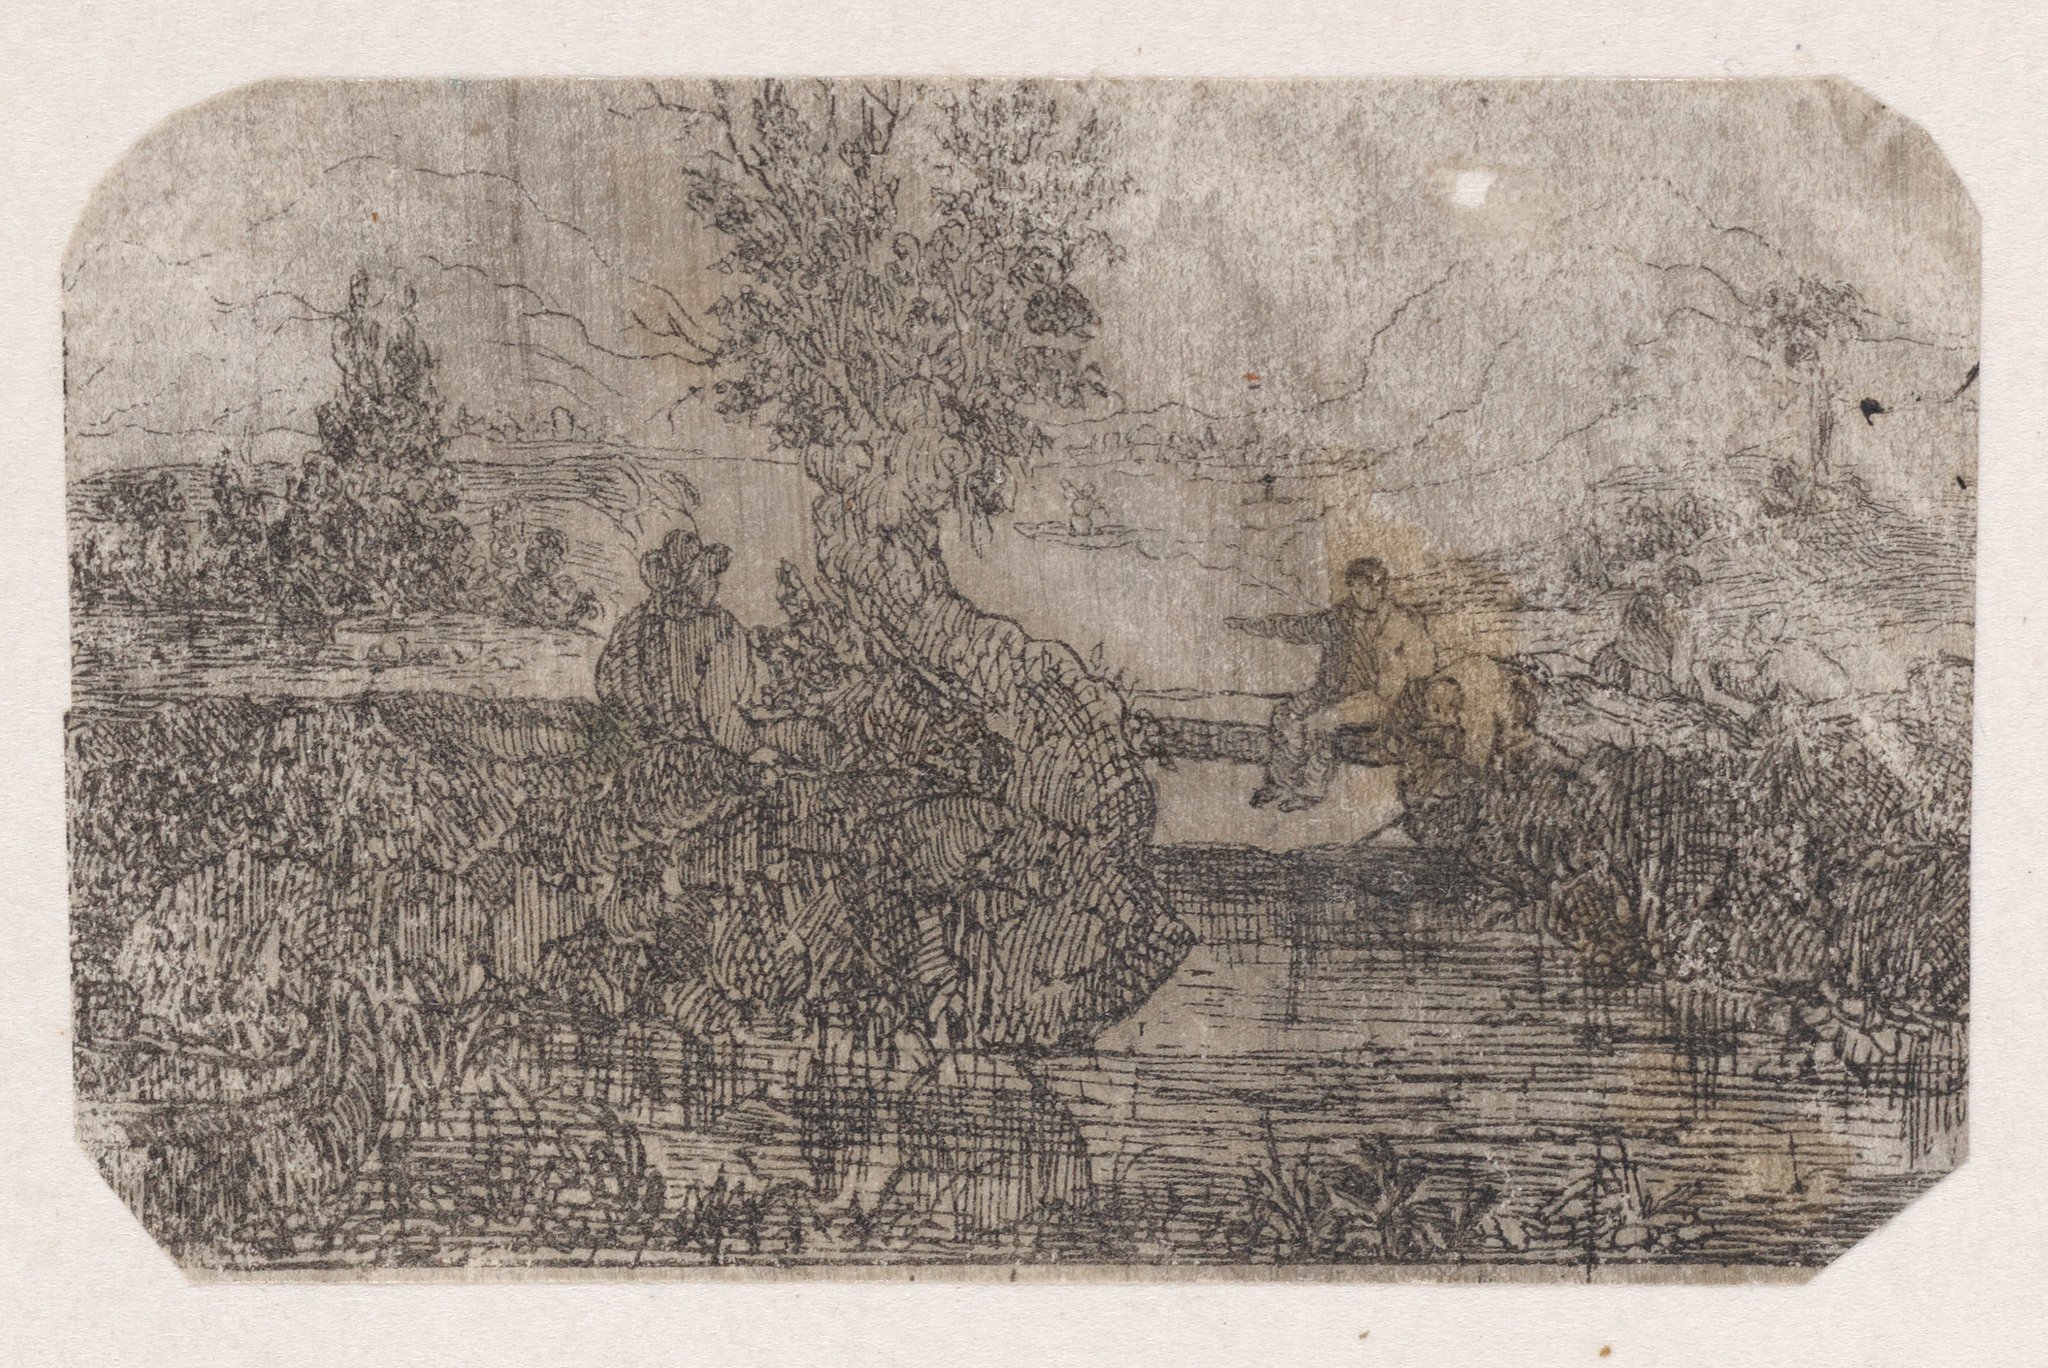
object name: print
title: Paysans se Reposant (Peasants Resting)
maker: rodolphe bresdin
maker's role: artist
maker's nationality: french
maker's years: 1822-1885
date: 1801-1900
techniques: etching